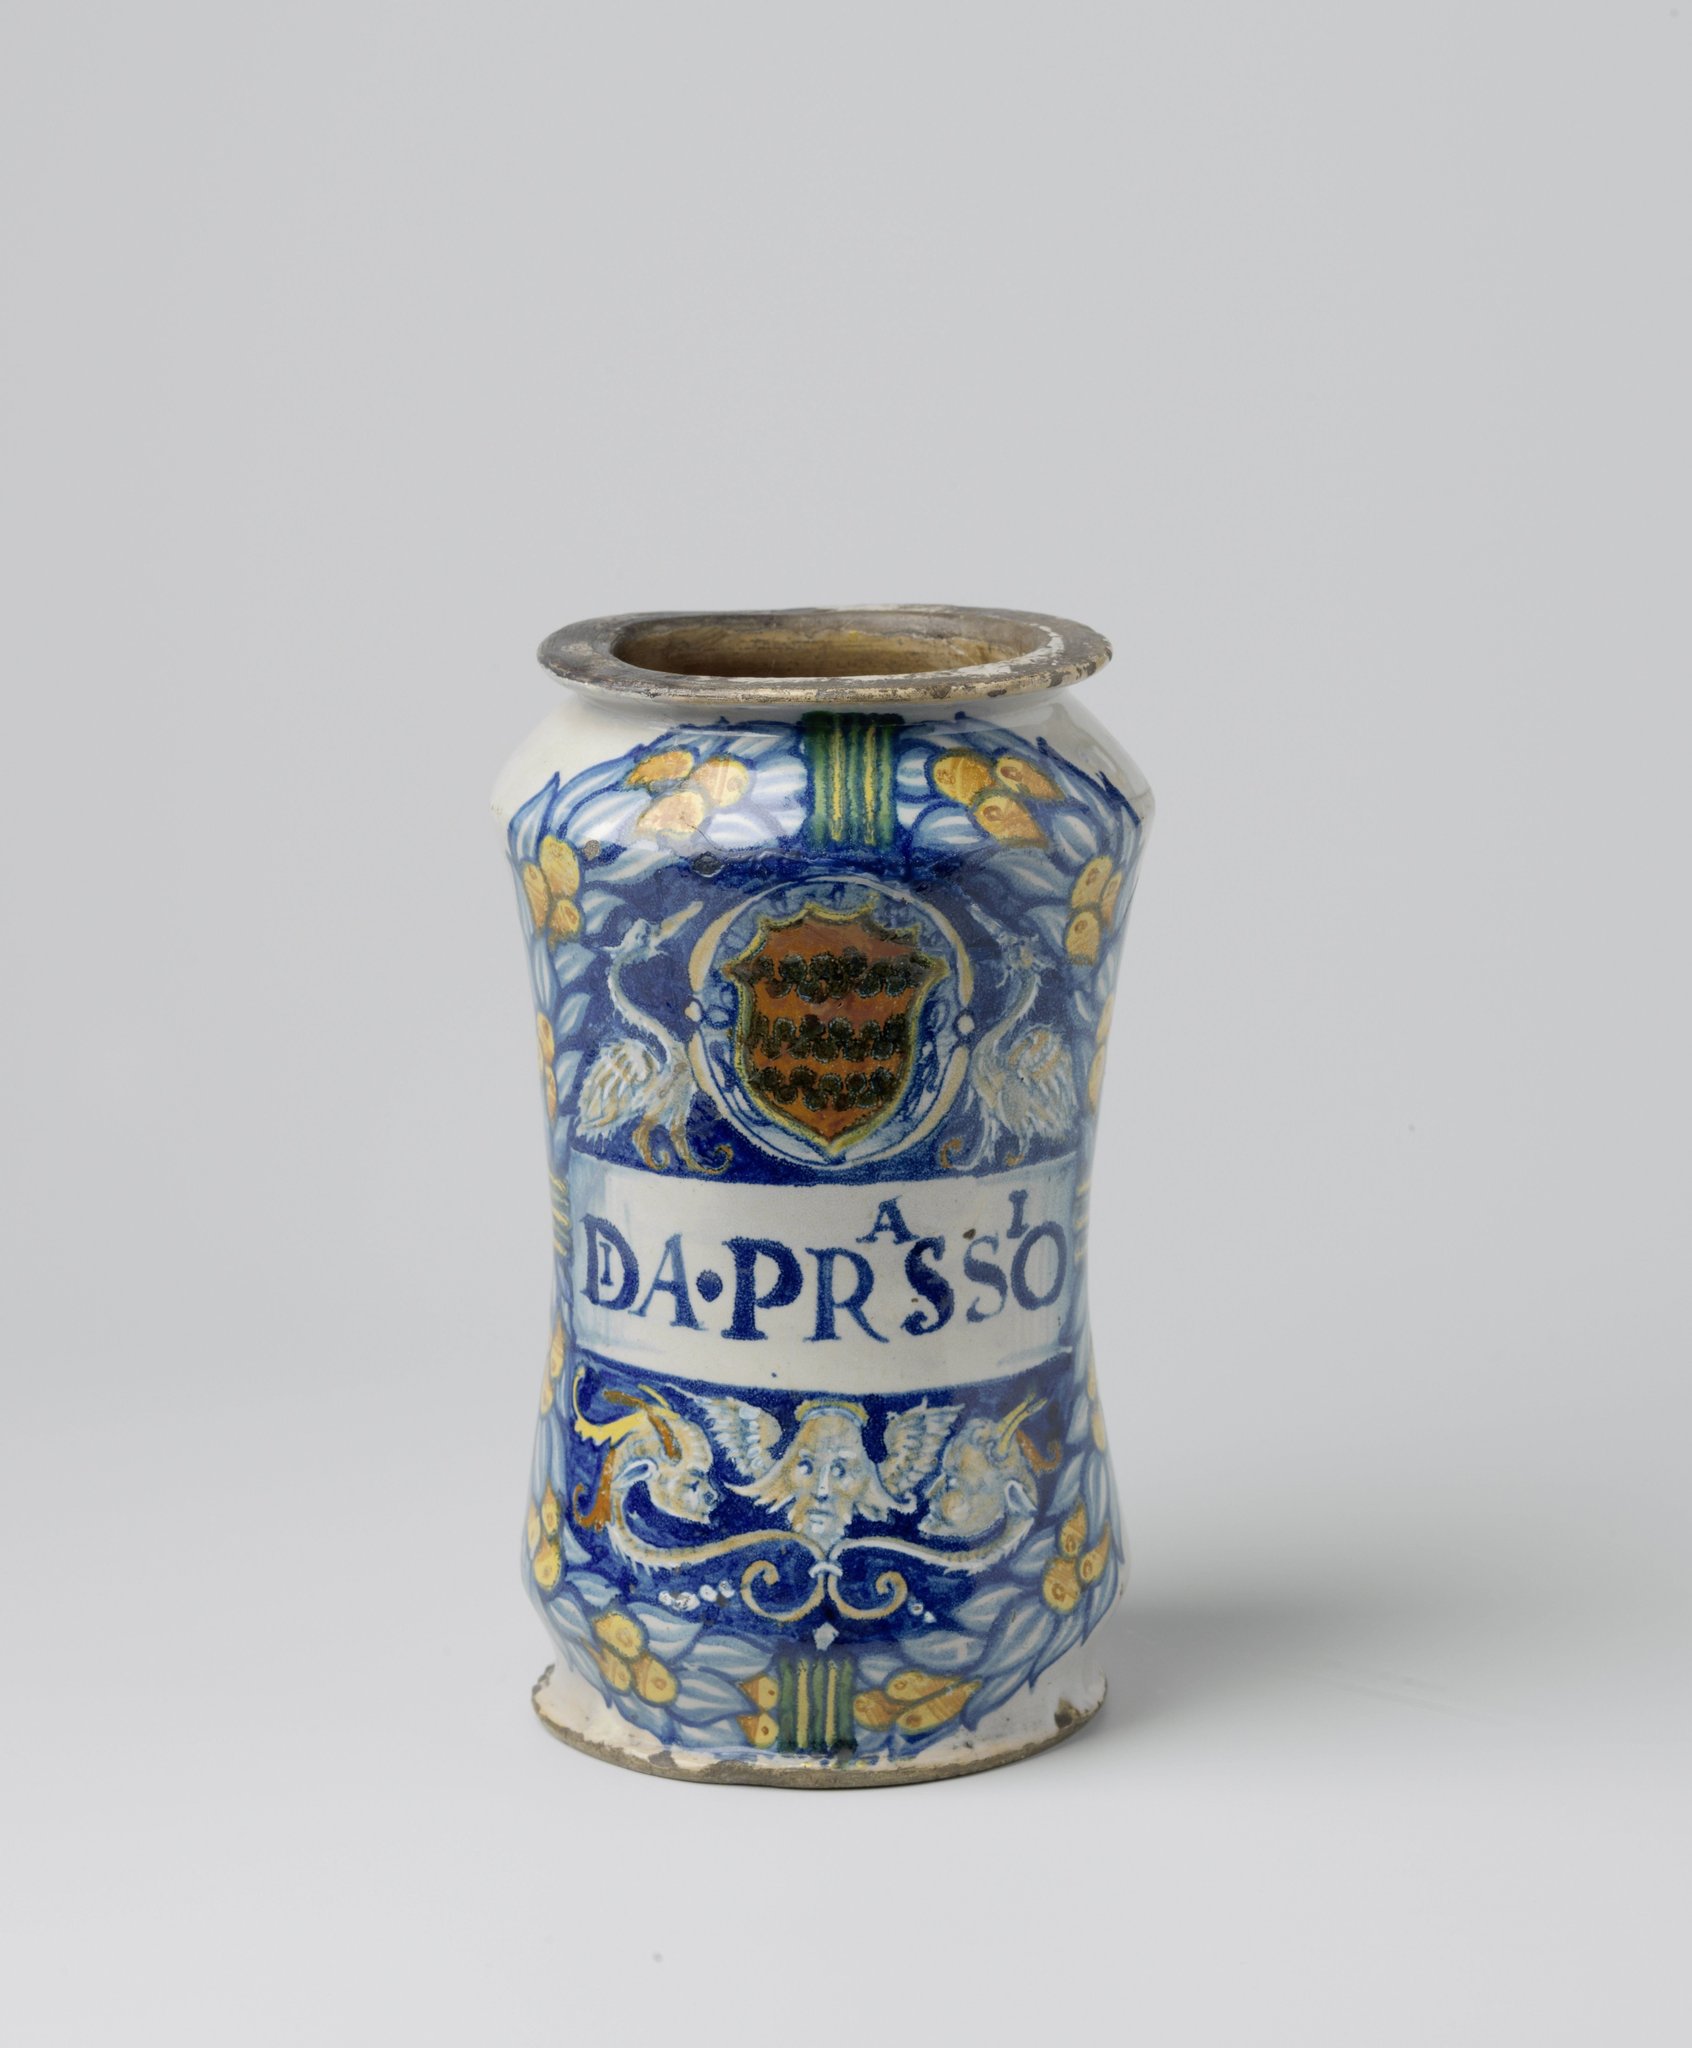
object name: pot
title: Albarello, veelkleurig beschilderd met een wapen met ter weerszijden de kop van een griffioen en een banderol met opschrift: DA PRASSIO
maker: Anonymous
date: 1500-1530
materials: earthenware, glaze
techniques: maiolica, painted, polychromy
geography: castel durante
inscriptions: label: ‘bewaarneming vom Rath 121’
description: Two drug jars (Albarelli) with the inscription DIA PRASSIO (a highly complex laxative) and TERA PIGRA (electuary laxative). Deruta, c. 1500 - 1530. J.W. Edwin vom Rath bequest, 1941.